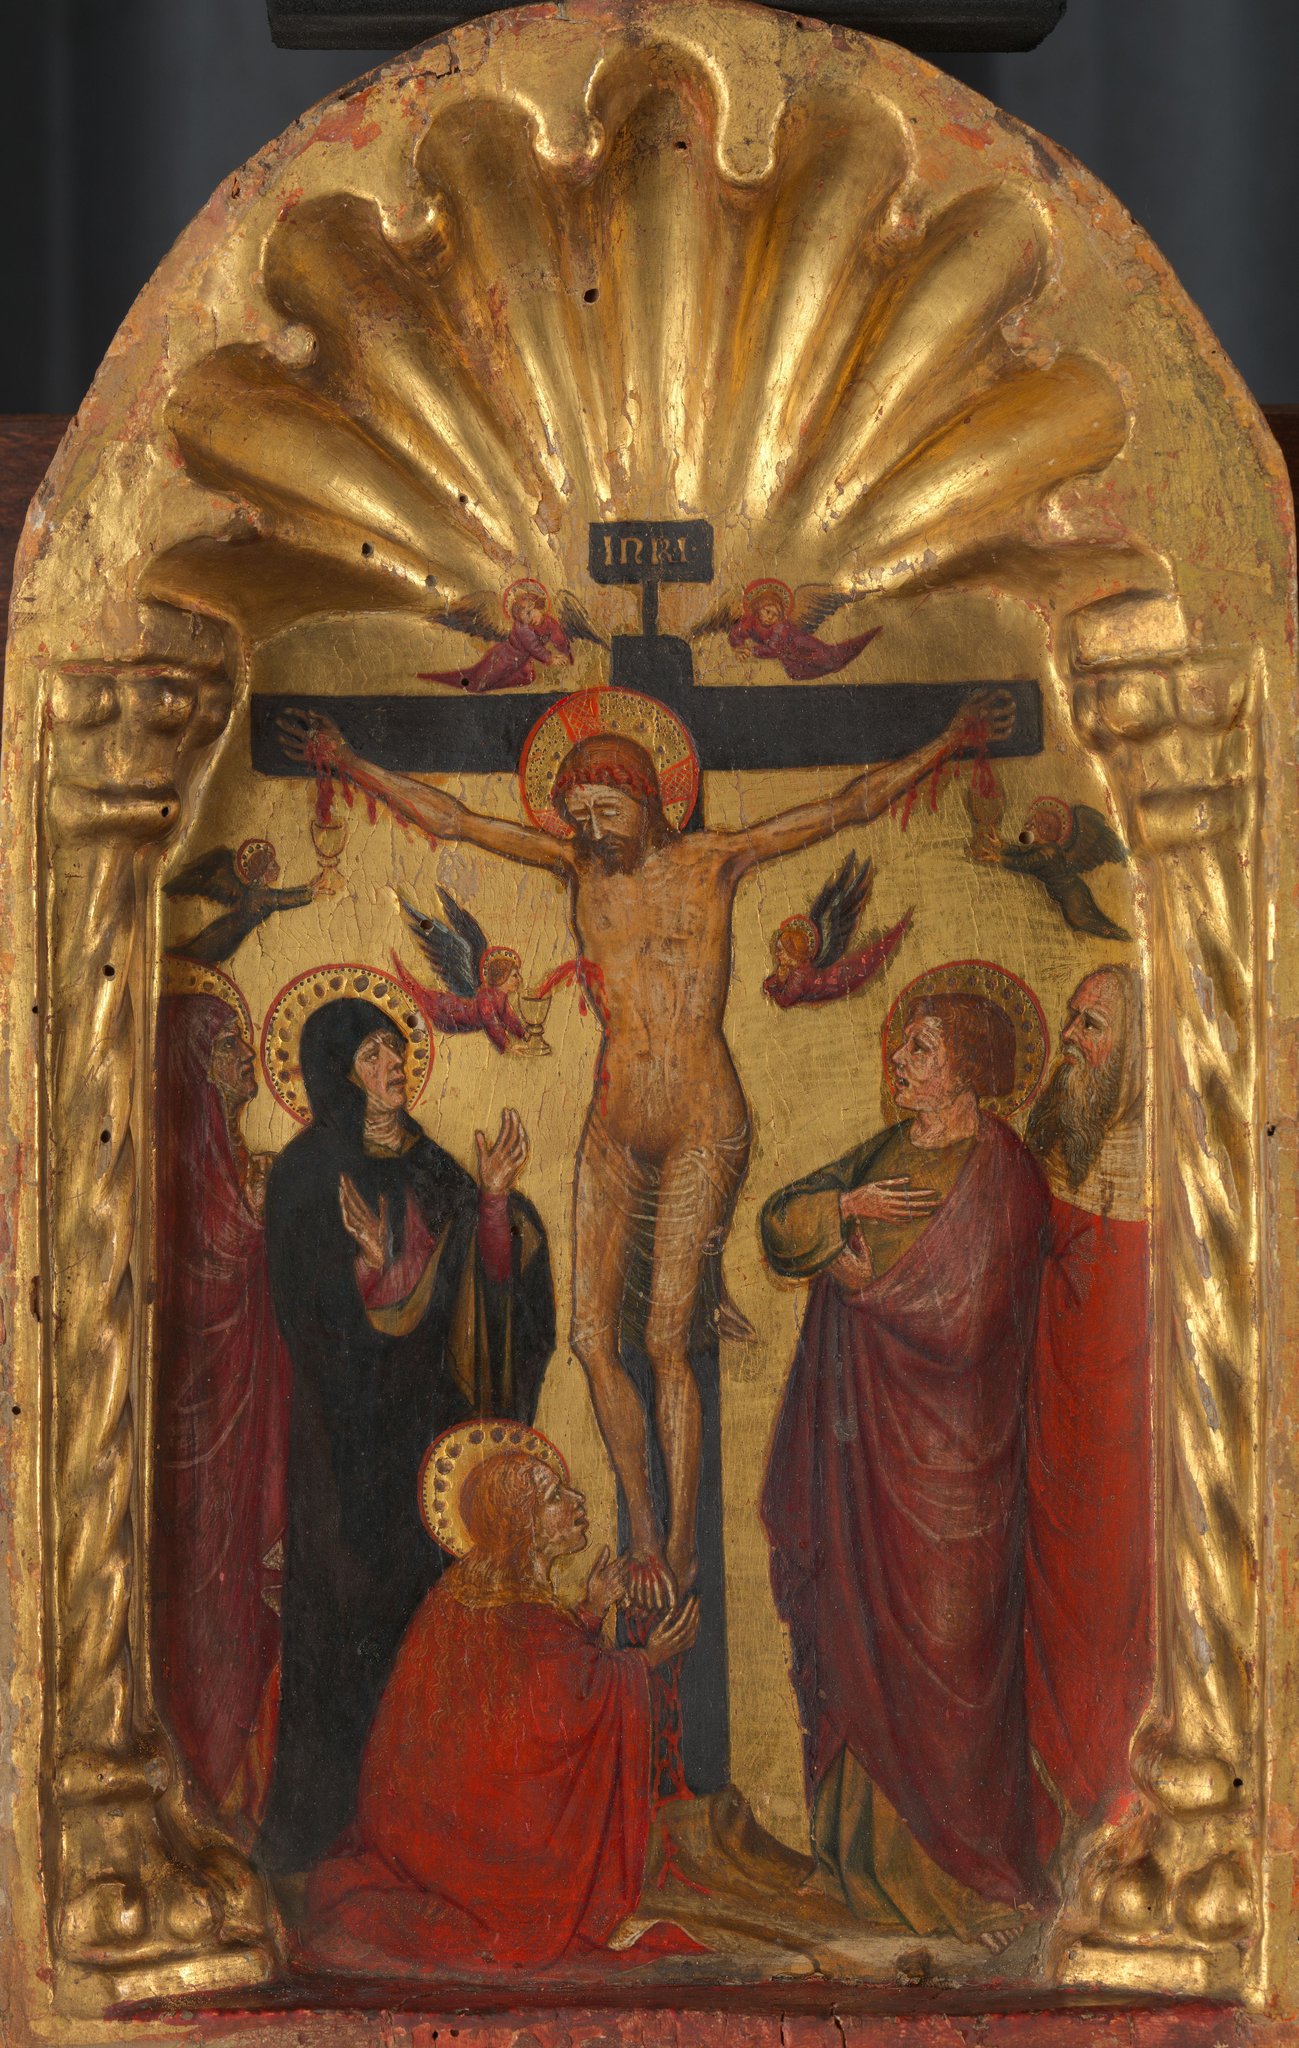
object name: painting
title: The Crucifixion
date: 1360-1370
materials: panel, paint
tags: crucified christ, with particular persons under the cross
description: Kruisiging. Christus aan het kruis. Links de twee Maria's, rechts Johannes en Jozef van Arimathea; Maria Magdalena knielt bij de voet van het kruis. Engelen vangen het bloed van Christus op in kelken. Gouden achtergrond. Met geïntegreerde lijst.